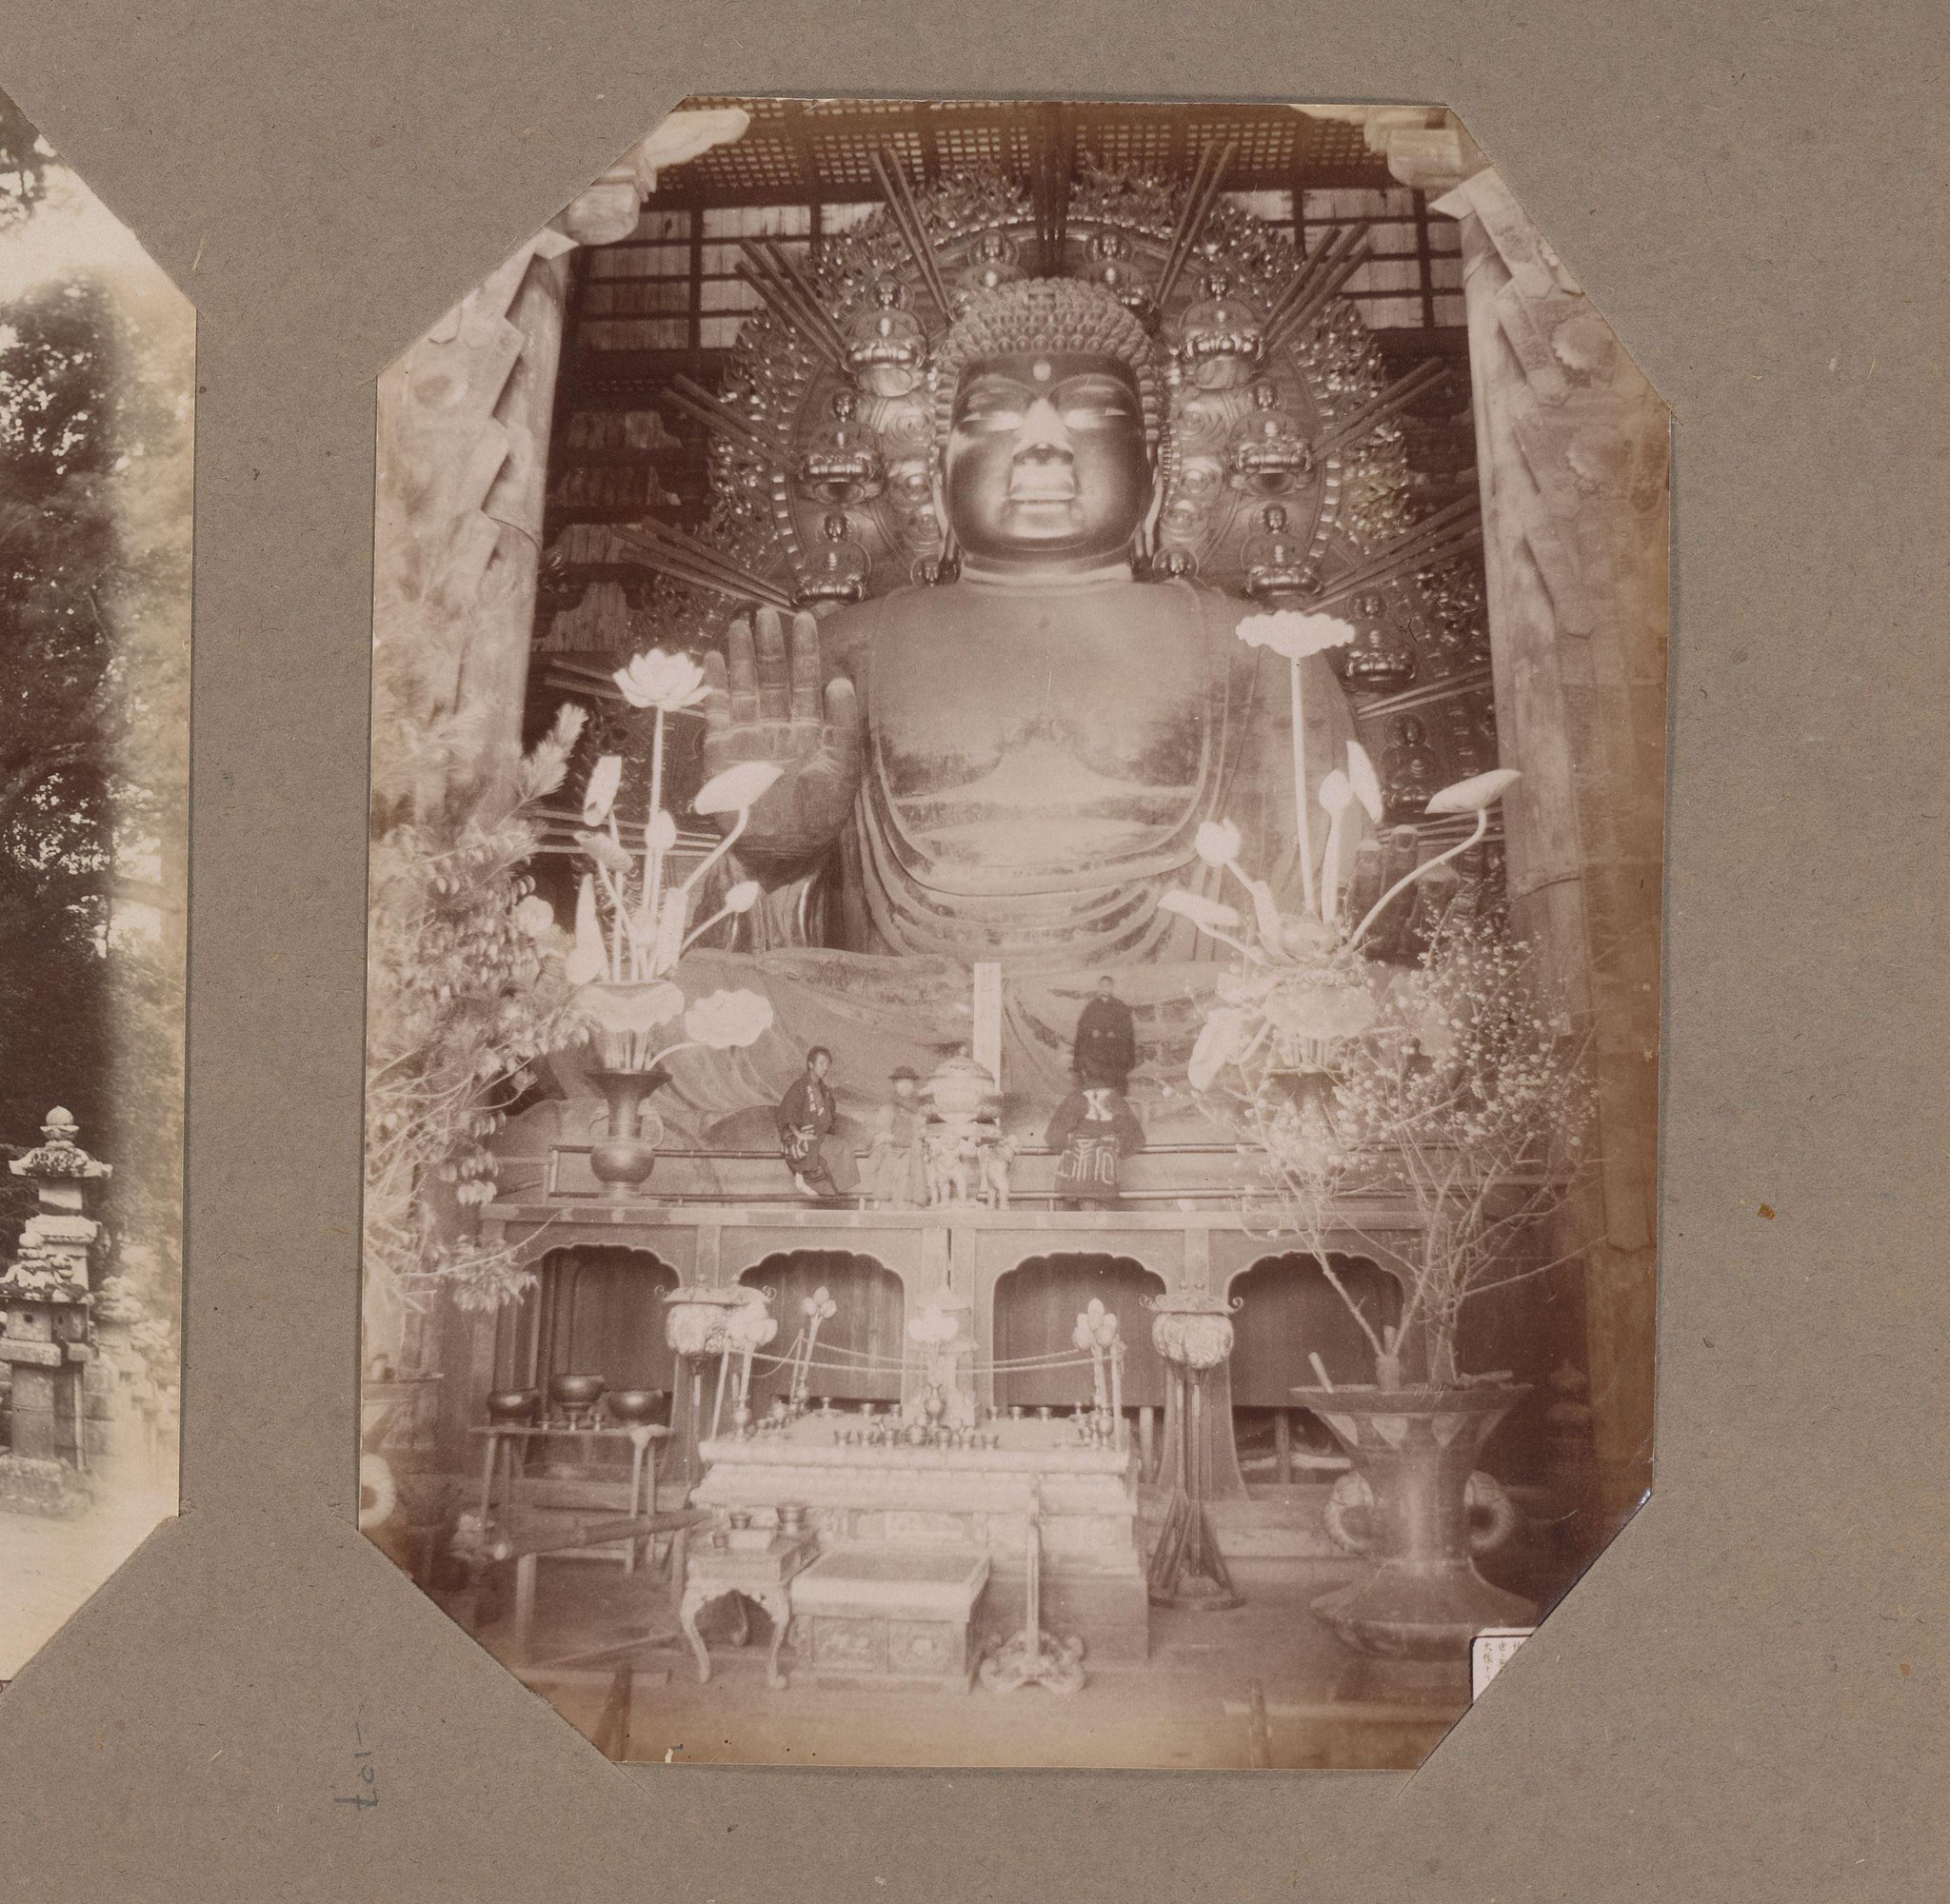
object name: album leaf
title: Daibutsu (Grote Boeddha) in Nara, Japan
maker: Anonymous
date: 1890-1903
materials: paper, photographic support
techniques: albumen print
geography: nara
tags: buddha, founder of buddhism, statues, paintings, etc. ~ objects of worship (hinduism, buddhism, jainism)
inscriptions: inscription: ‘14 / Large Coppelman in Nara’